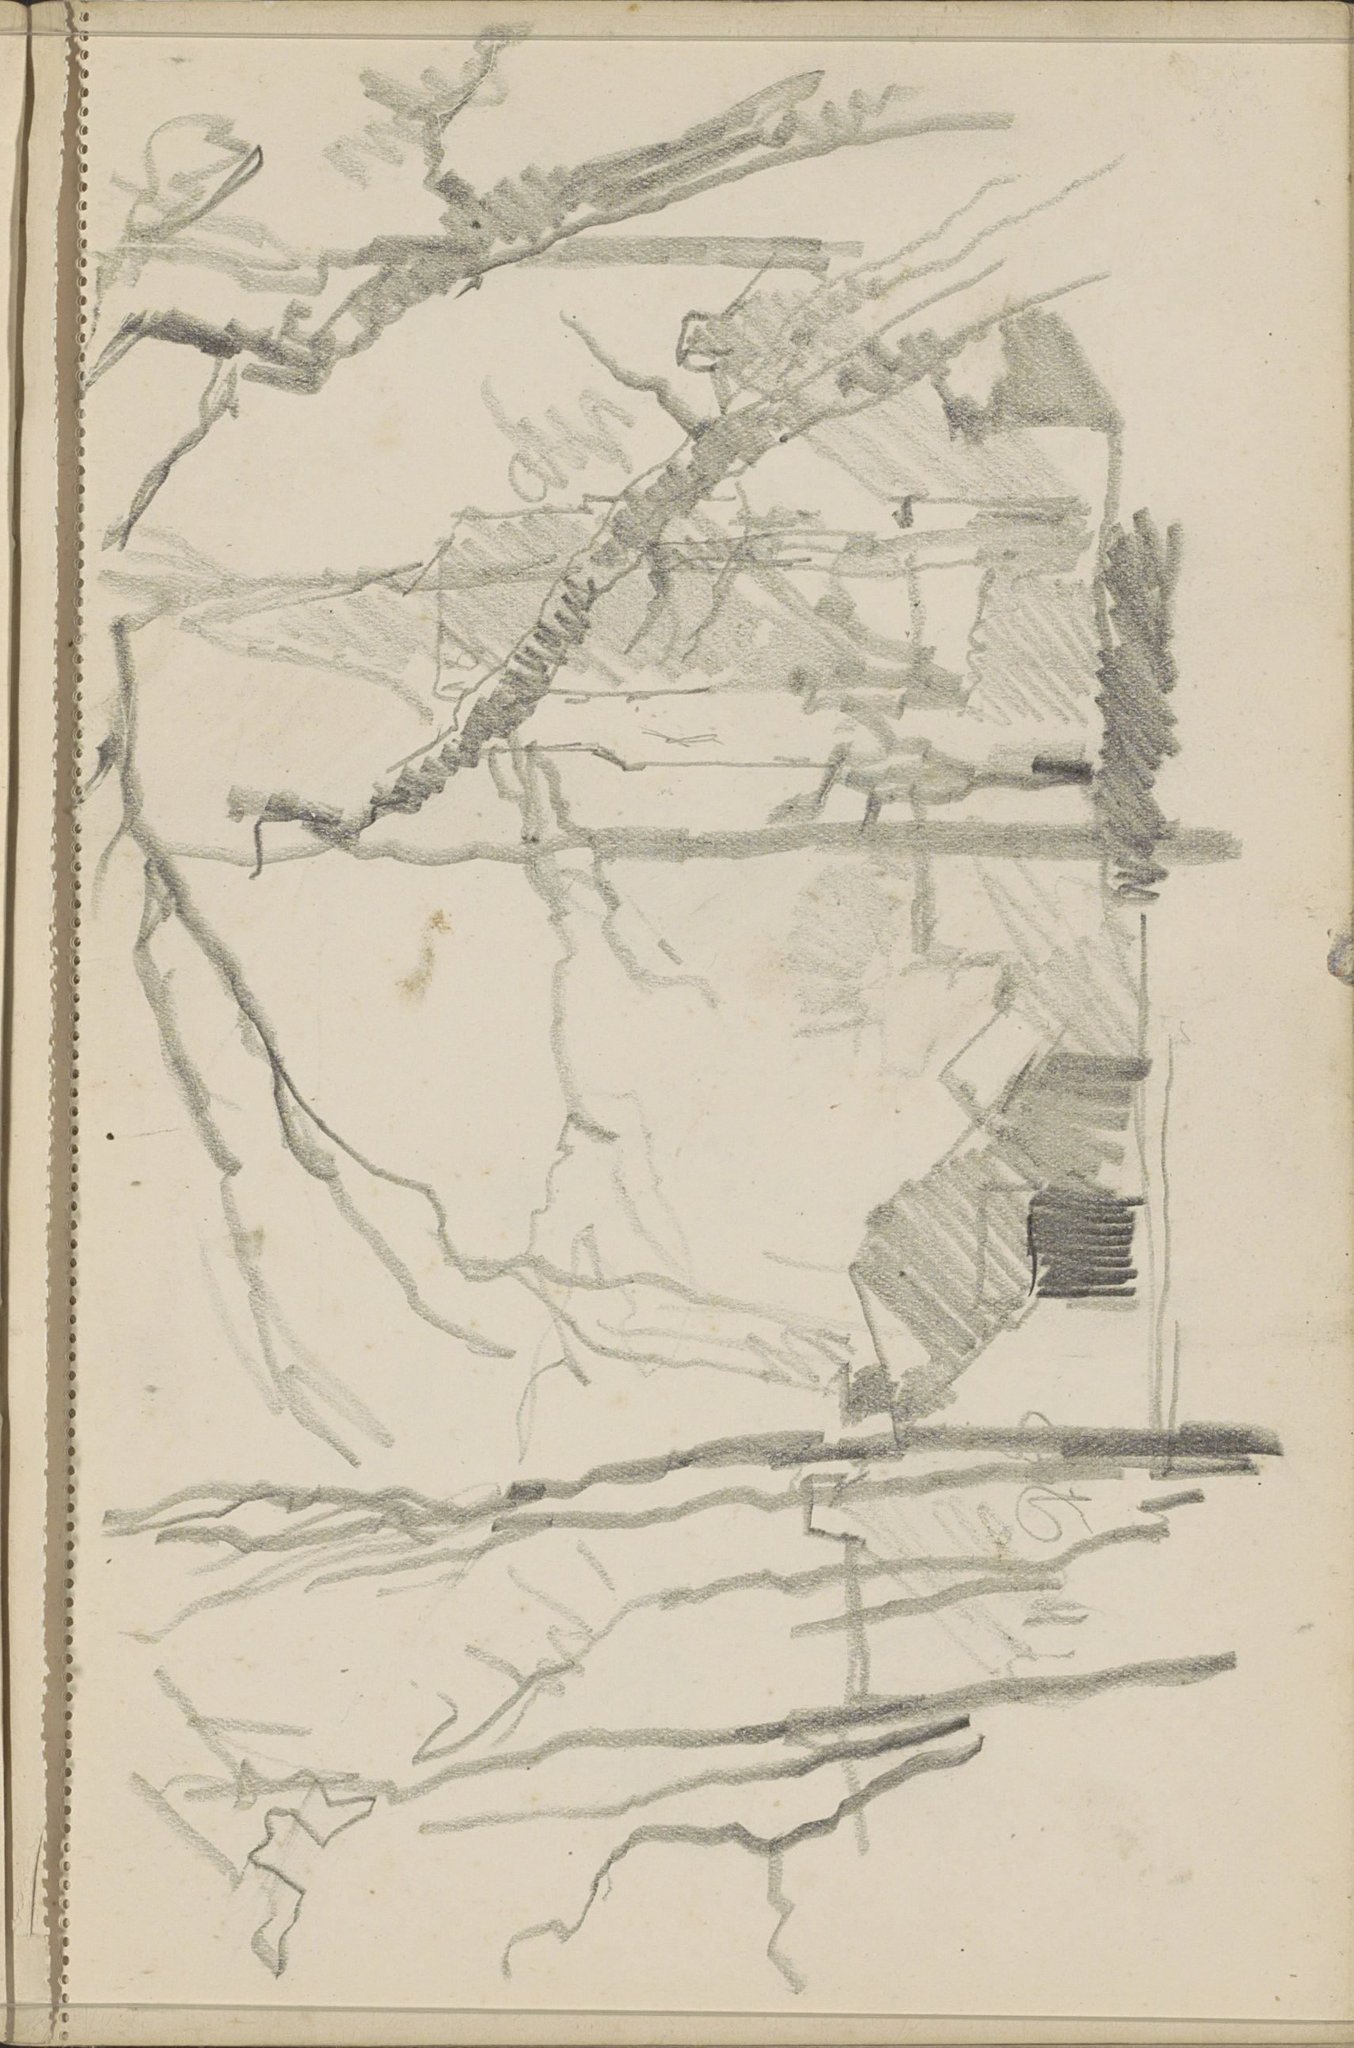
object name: sketchbook leaf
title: Huizen en een kerktoren tussen de bomen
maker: cornelis vreedenburgh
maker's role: draughtsman, print maker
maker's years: 1880-1946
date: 1890-1946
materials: paper, pencil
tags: prospect of village, silhouette of village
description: Blad 28 recto uit een schetsboek met 59 bladen.